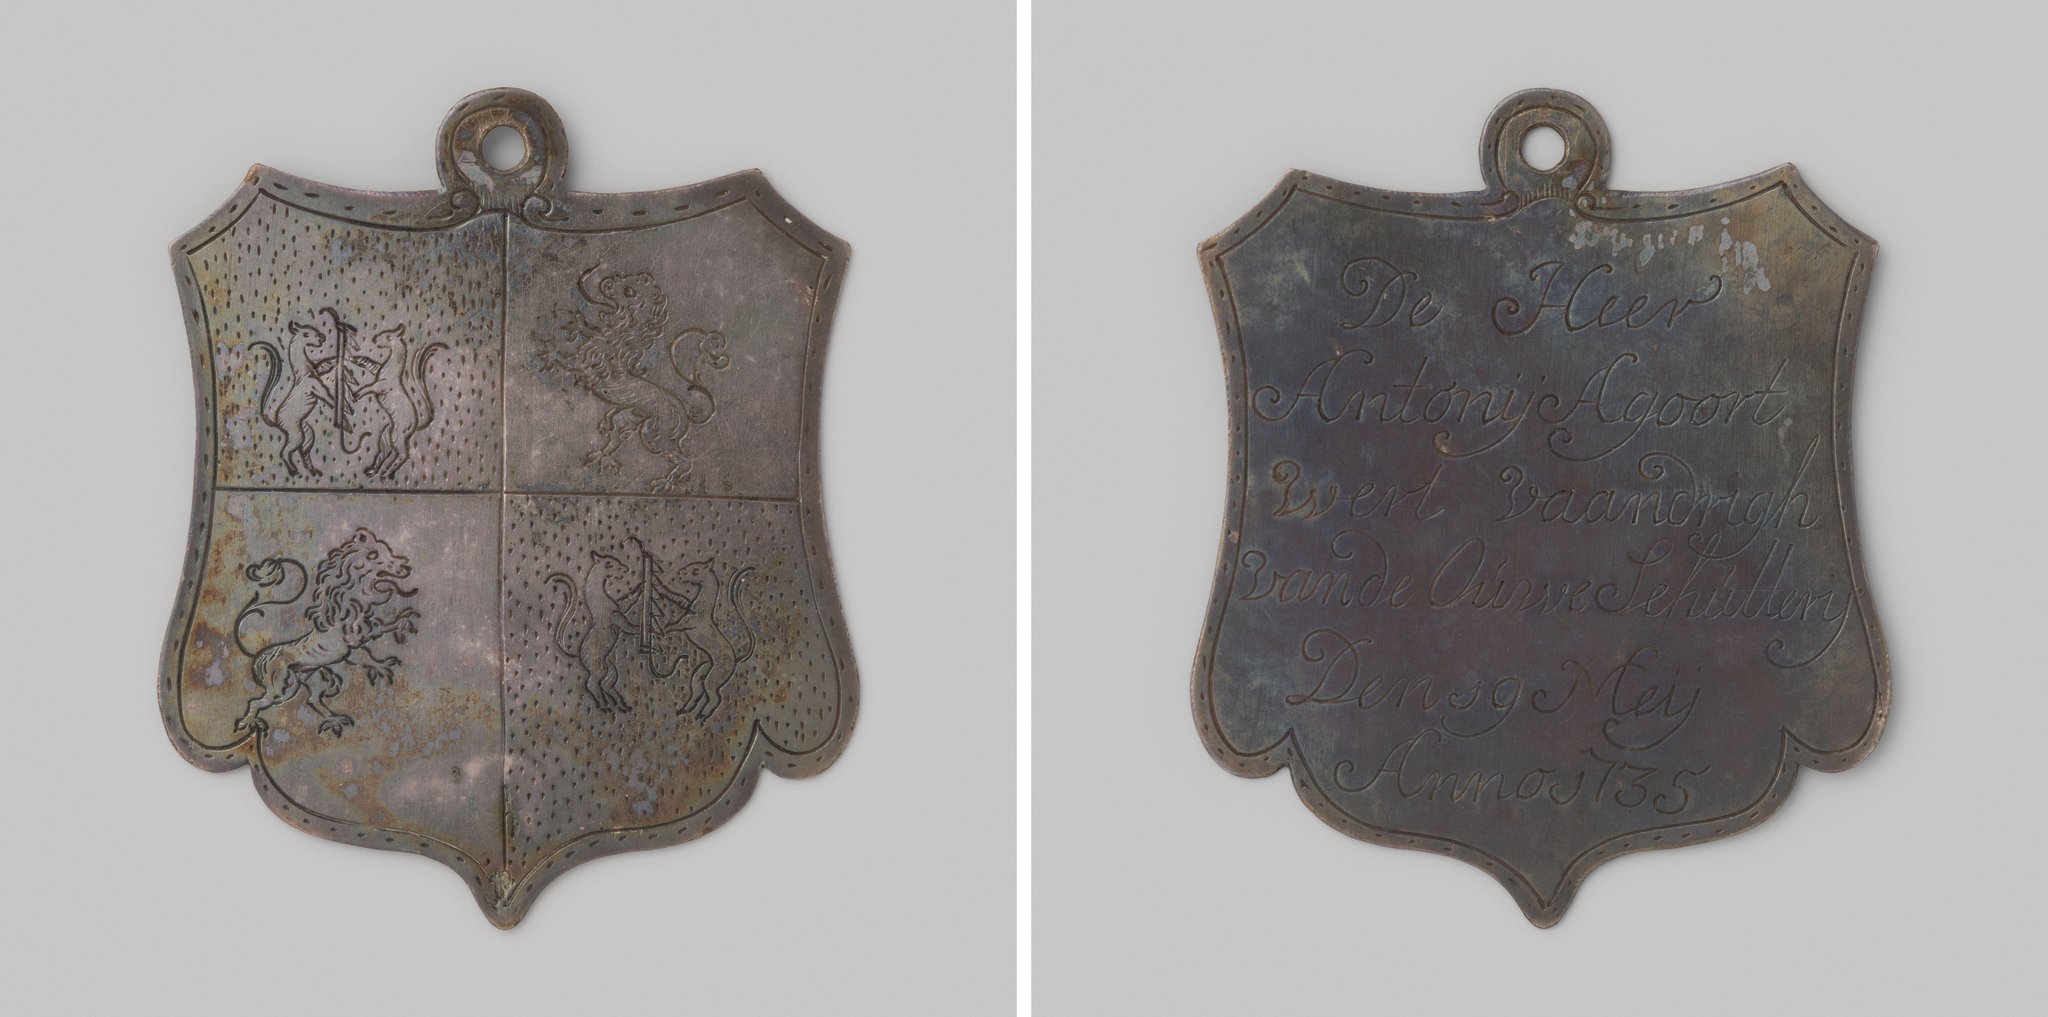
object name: insignia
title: Penning in de vorm van een schild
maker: Anonymous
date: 1735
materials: metal